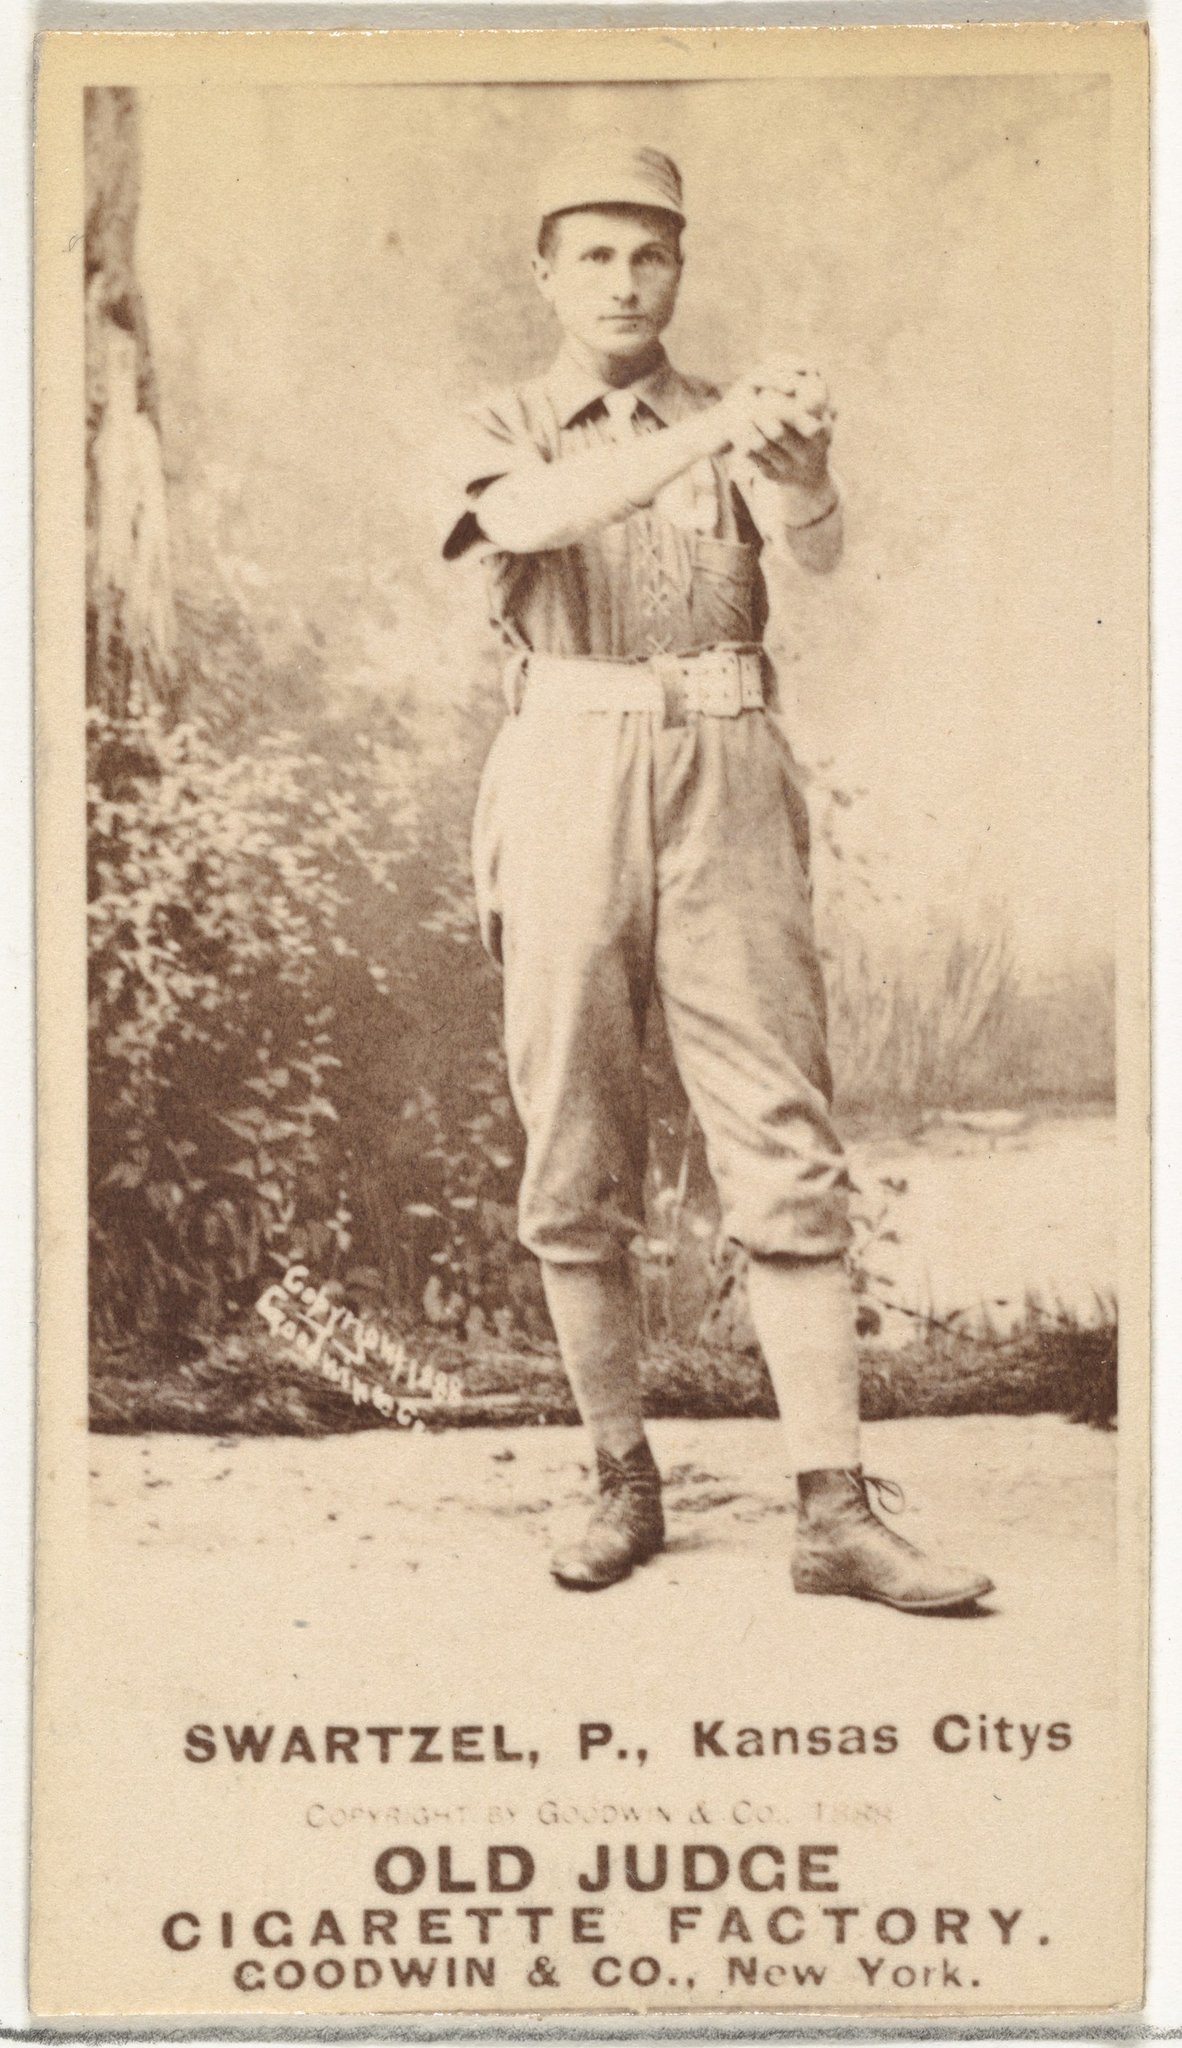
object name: baseball card, photograph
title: Parke B. Swartzel, Pitcher, Kansas City Cowboys, from the Old Judge series (N172) for Old Judge Cigarettes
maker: goodwin & company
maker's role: publisher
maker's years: 1850-1950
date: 1888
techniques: albumen silver print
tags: men,portraits,baseball,athletes